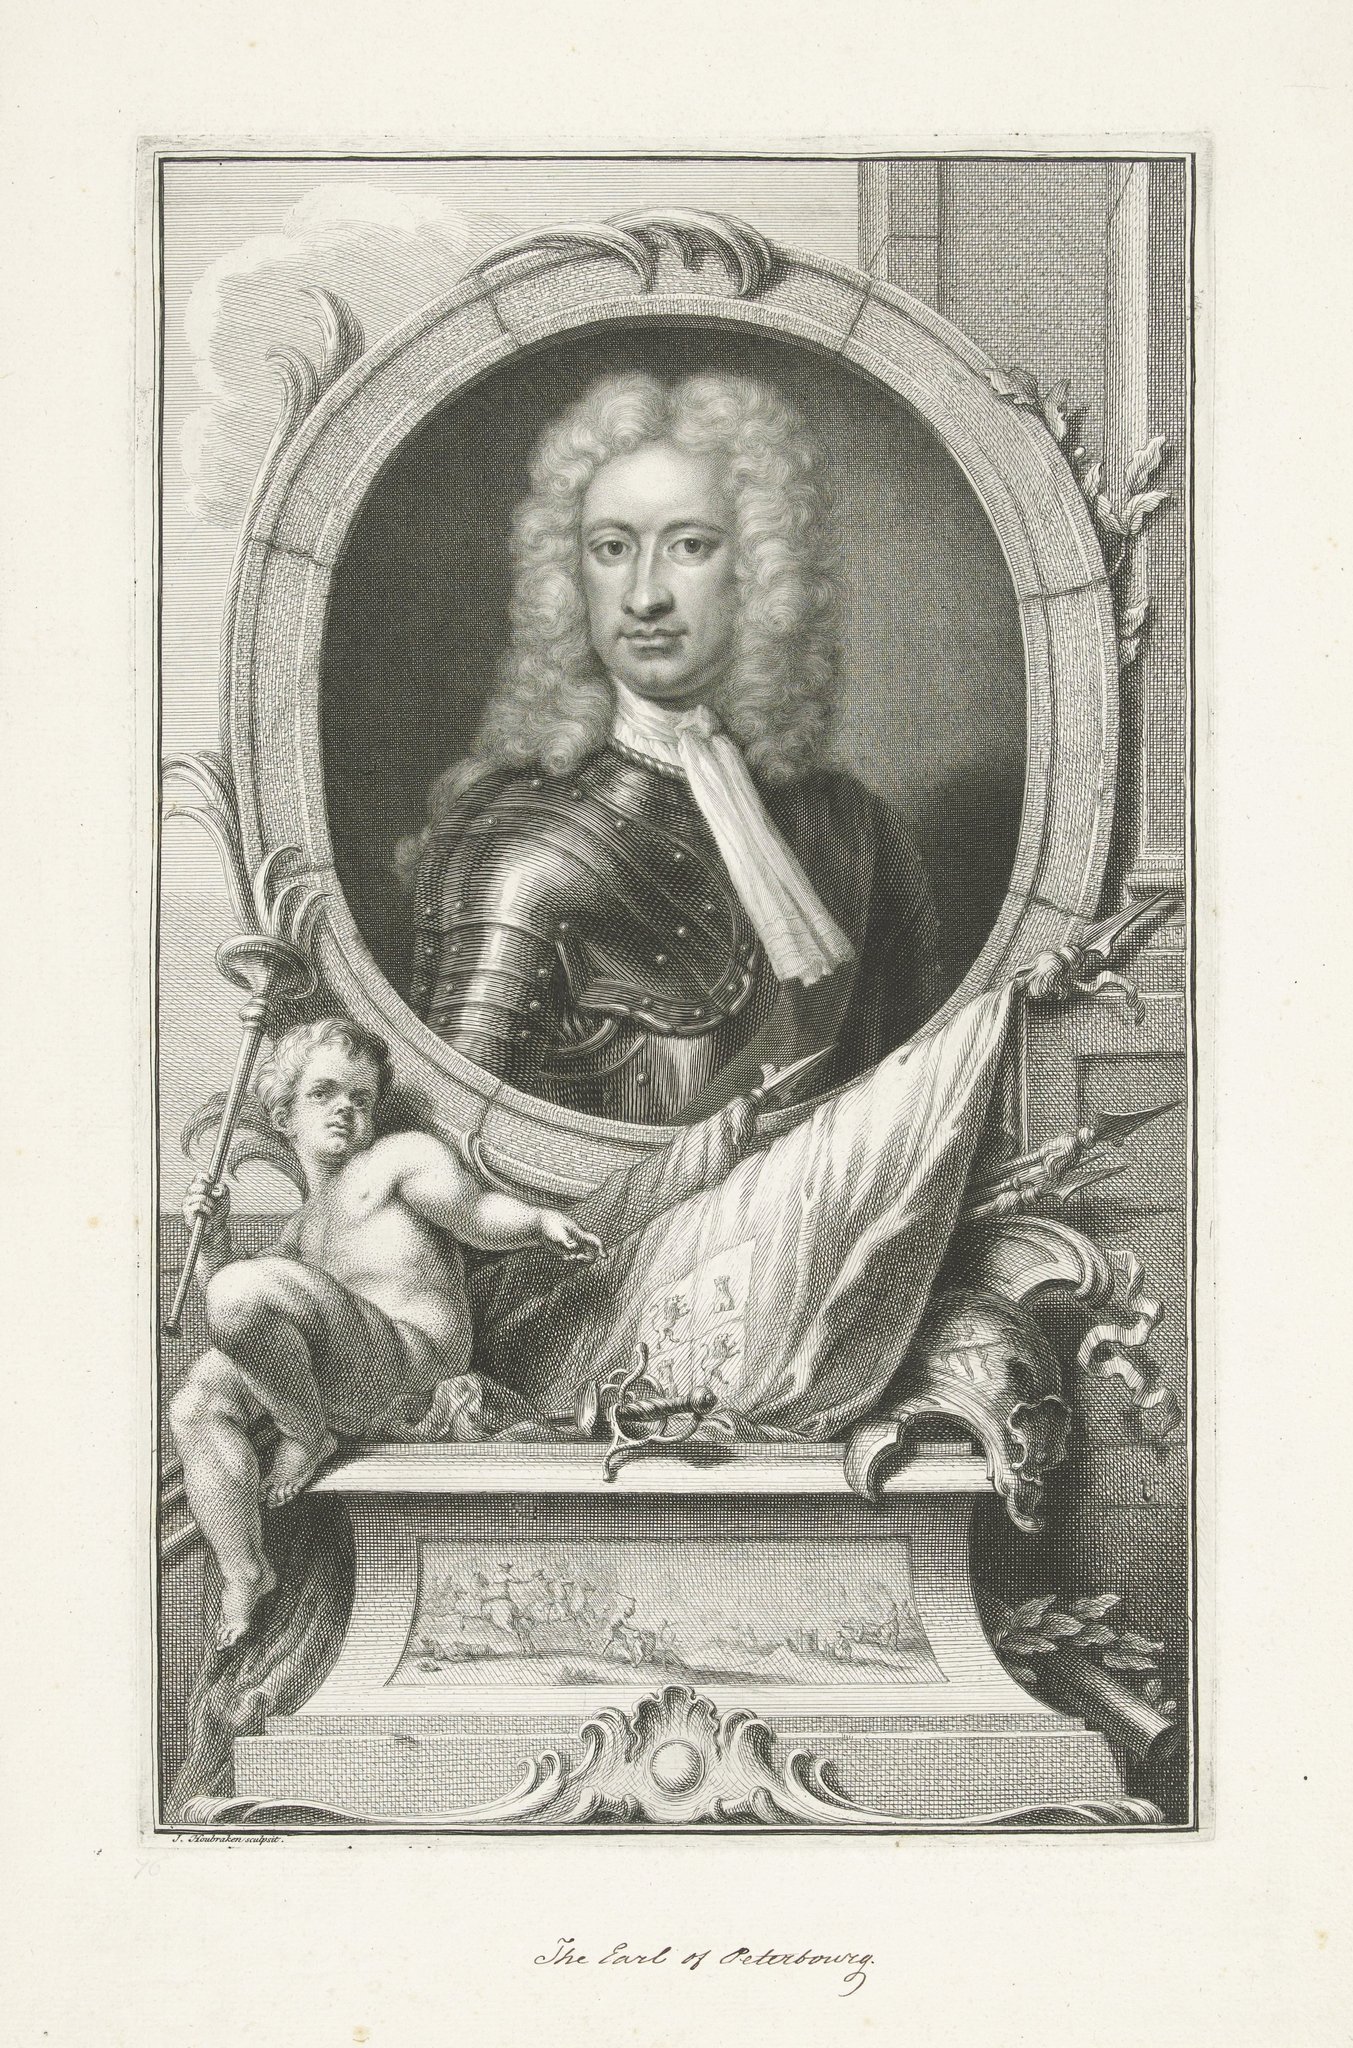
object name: print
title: Portret van Charles Mordaunt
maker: jacob houbraken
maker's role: draughtsman, print maker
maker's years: 1698-1780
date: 1741-1743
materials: paper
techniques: engraving, etching, pen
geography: amsterdam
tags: earl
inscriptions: name: ‘The Earl of Peterbourg’, collector's mark: Lugt 240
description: Prent ook gebruikt in: Thomas Birch. The heads of illustrious persons of Great Britain : engraved by Houbraken, and Vertue, with their lives and characters. London: John en Paul Knapton, 1743-1751.